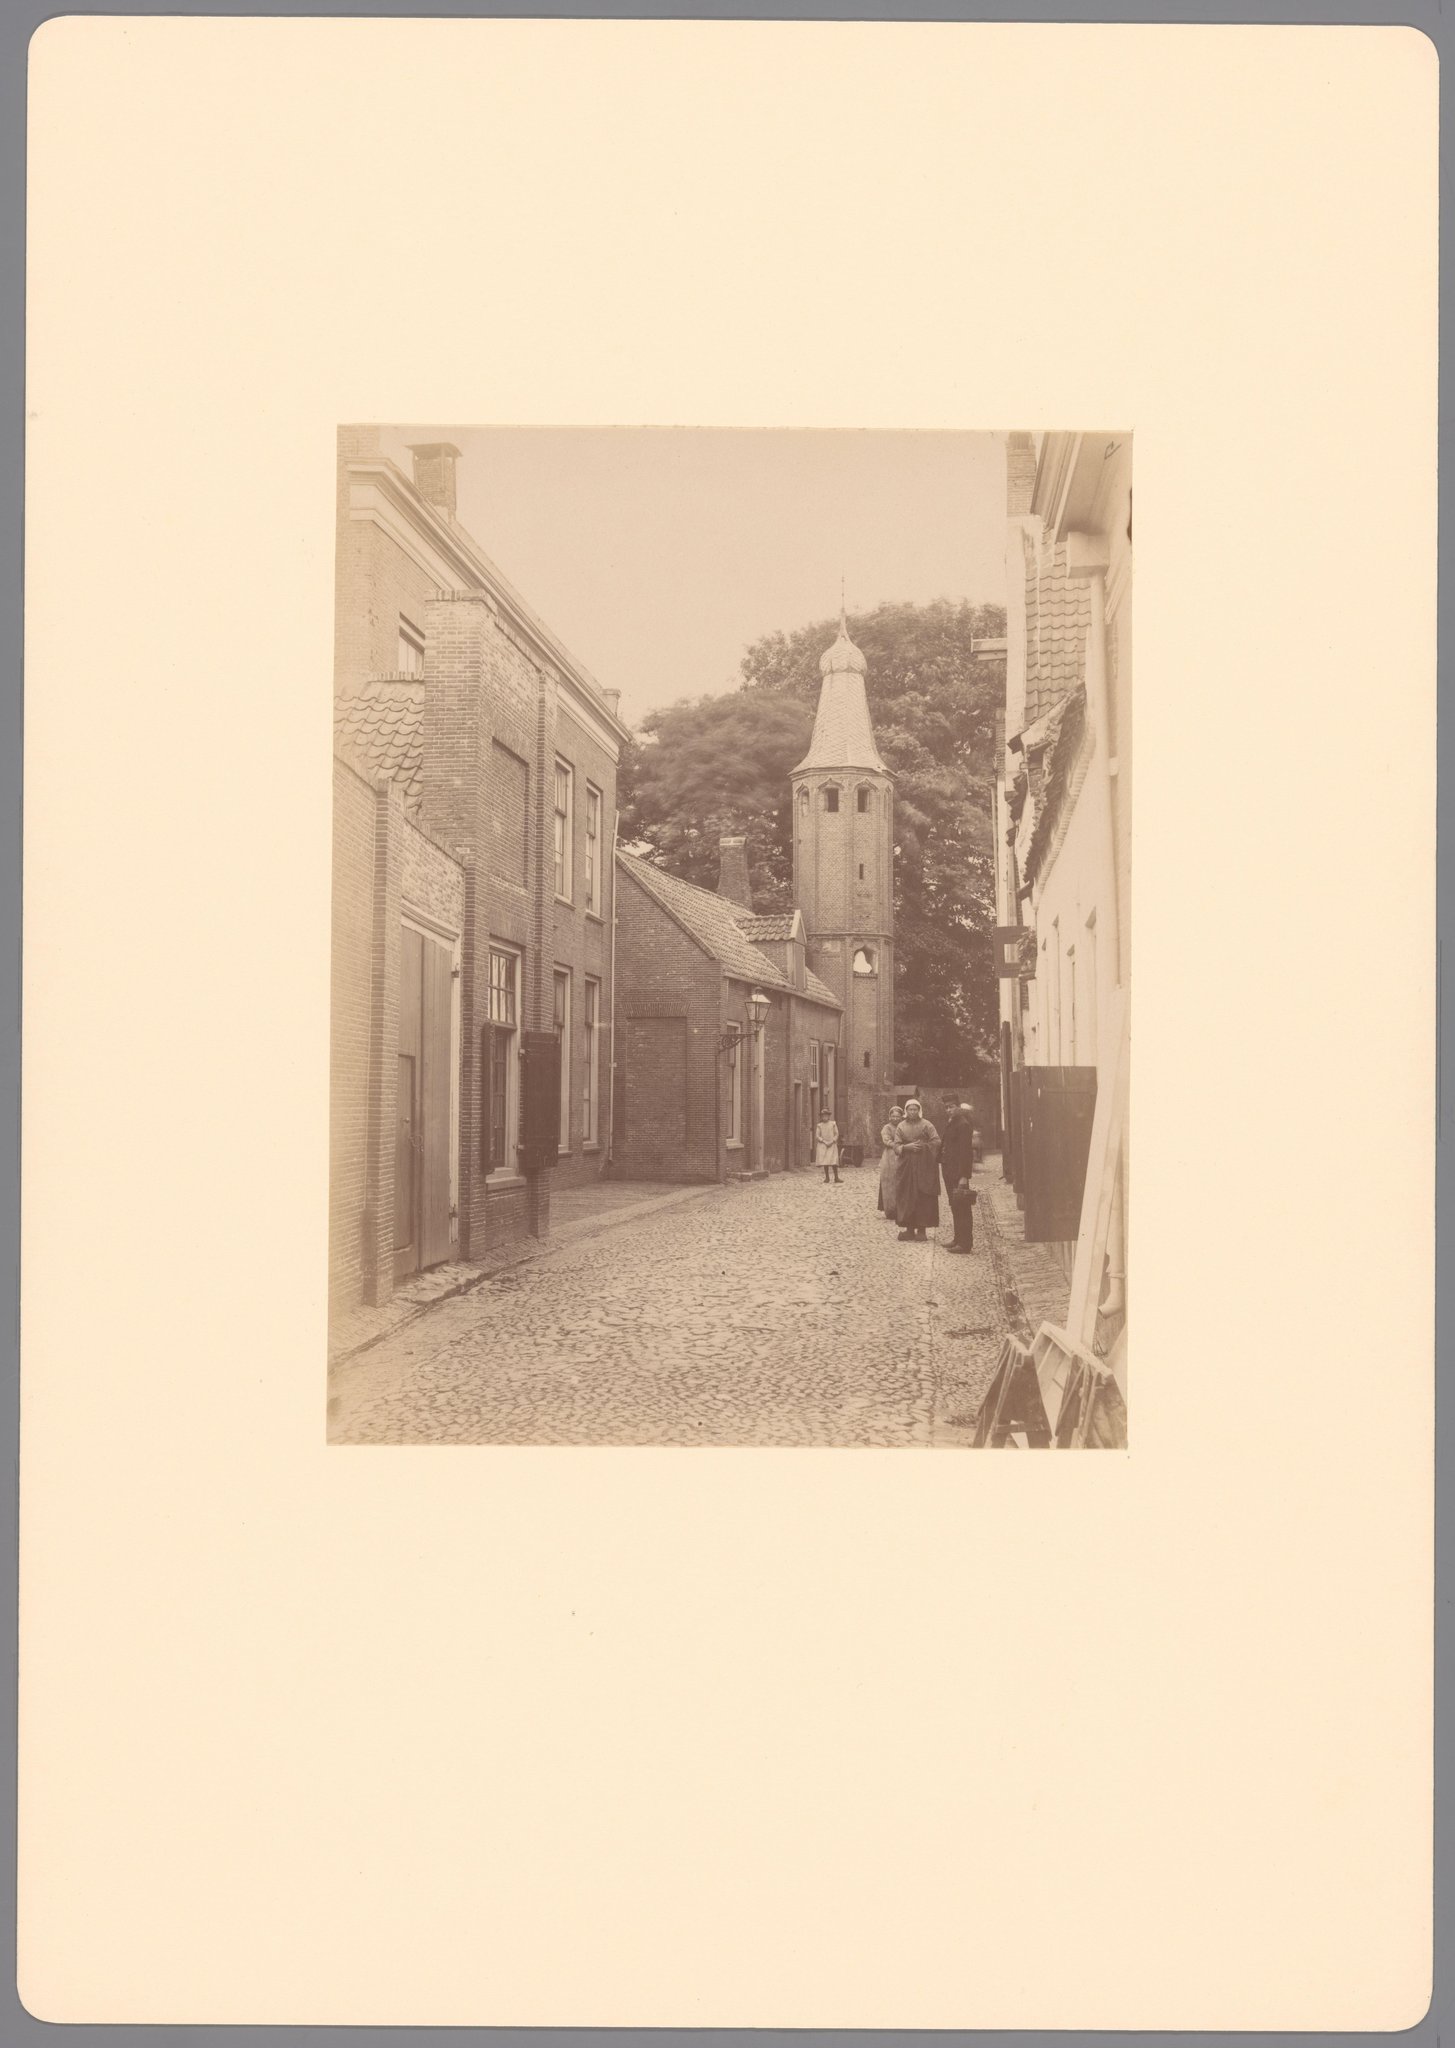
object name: photograph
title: Gezicht op de Universiteit van Harderwijk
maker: anoniem (monumentenzorg)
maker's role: fotograaf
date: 1910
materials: cardboard, photographic support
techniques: albumen print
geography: harderwijk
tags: university building, college, street (+ city(-scape) with figures, staffage)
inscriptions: annotation: ‘Harderwijk/ Overblijfsel van het voormaligen Atheneumgebouw juli 1910’, annotation: ‘c’